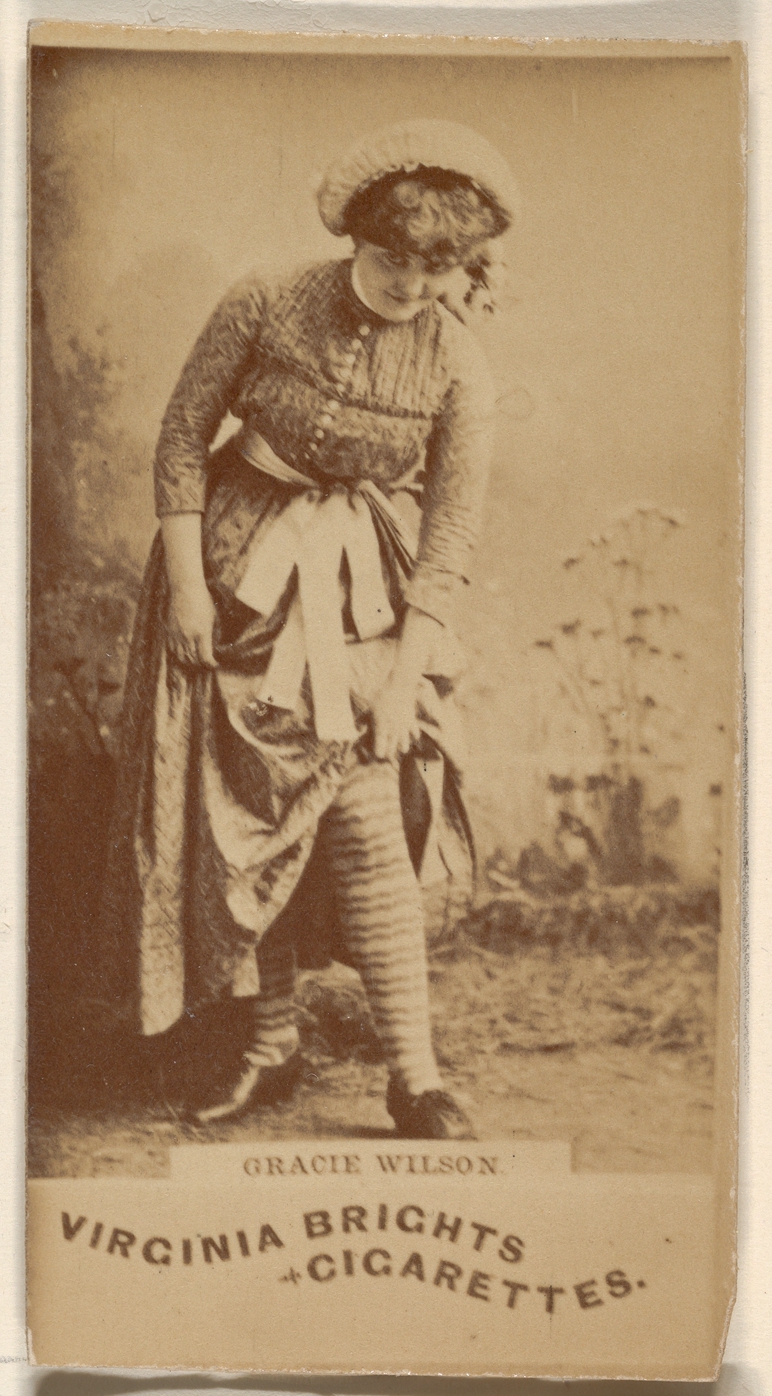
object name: photograph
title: Gracie Wilson, from the Actors and Actresses series (N45, Type 1) for Virginia Brights Cigarettes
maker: allen & ginter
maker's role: publisher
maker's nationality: american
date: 1888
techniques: albumen silver print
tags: portraits,women